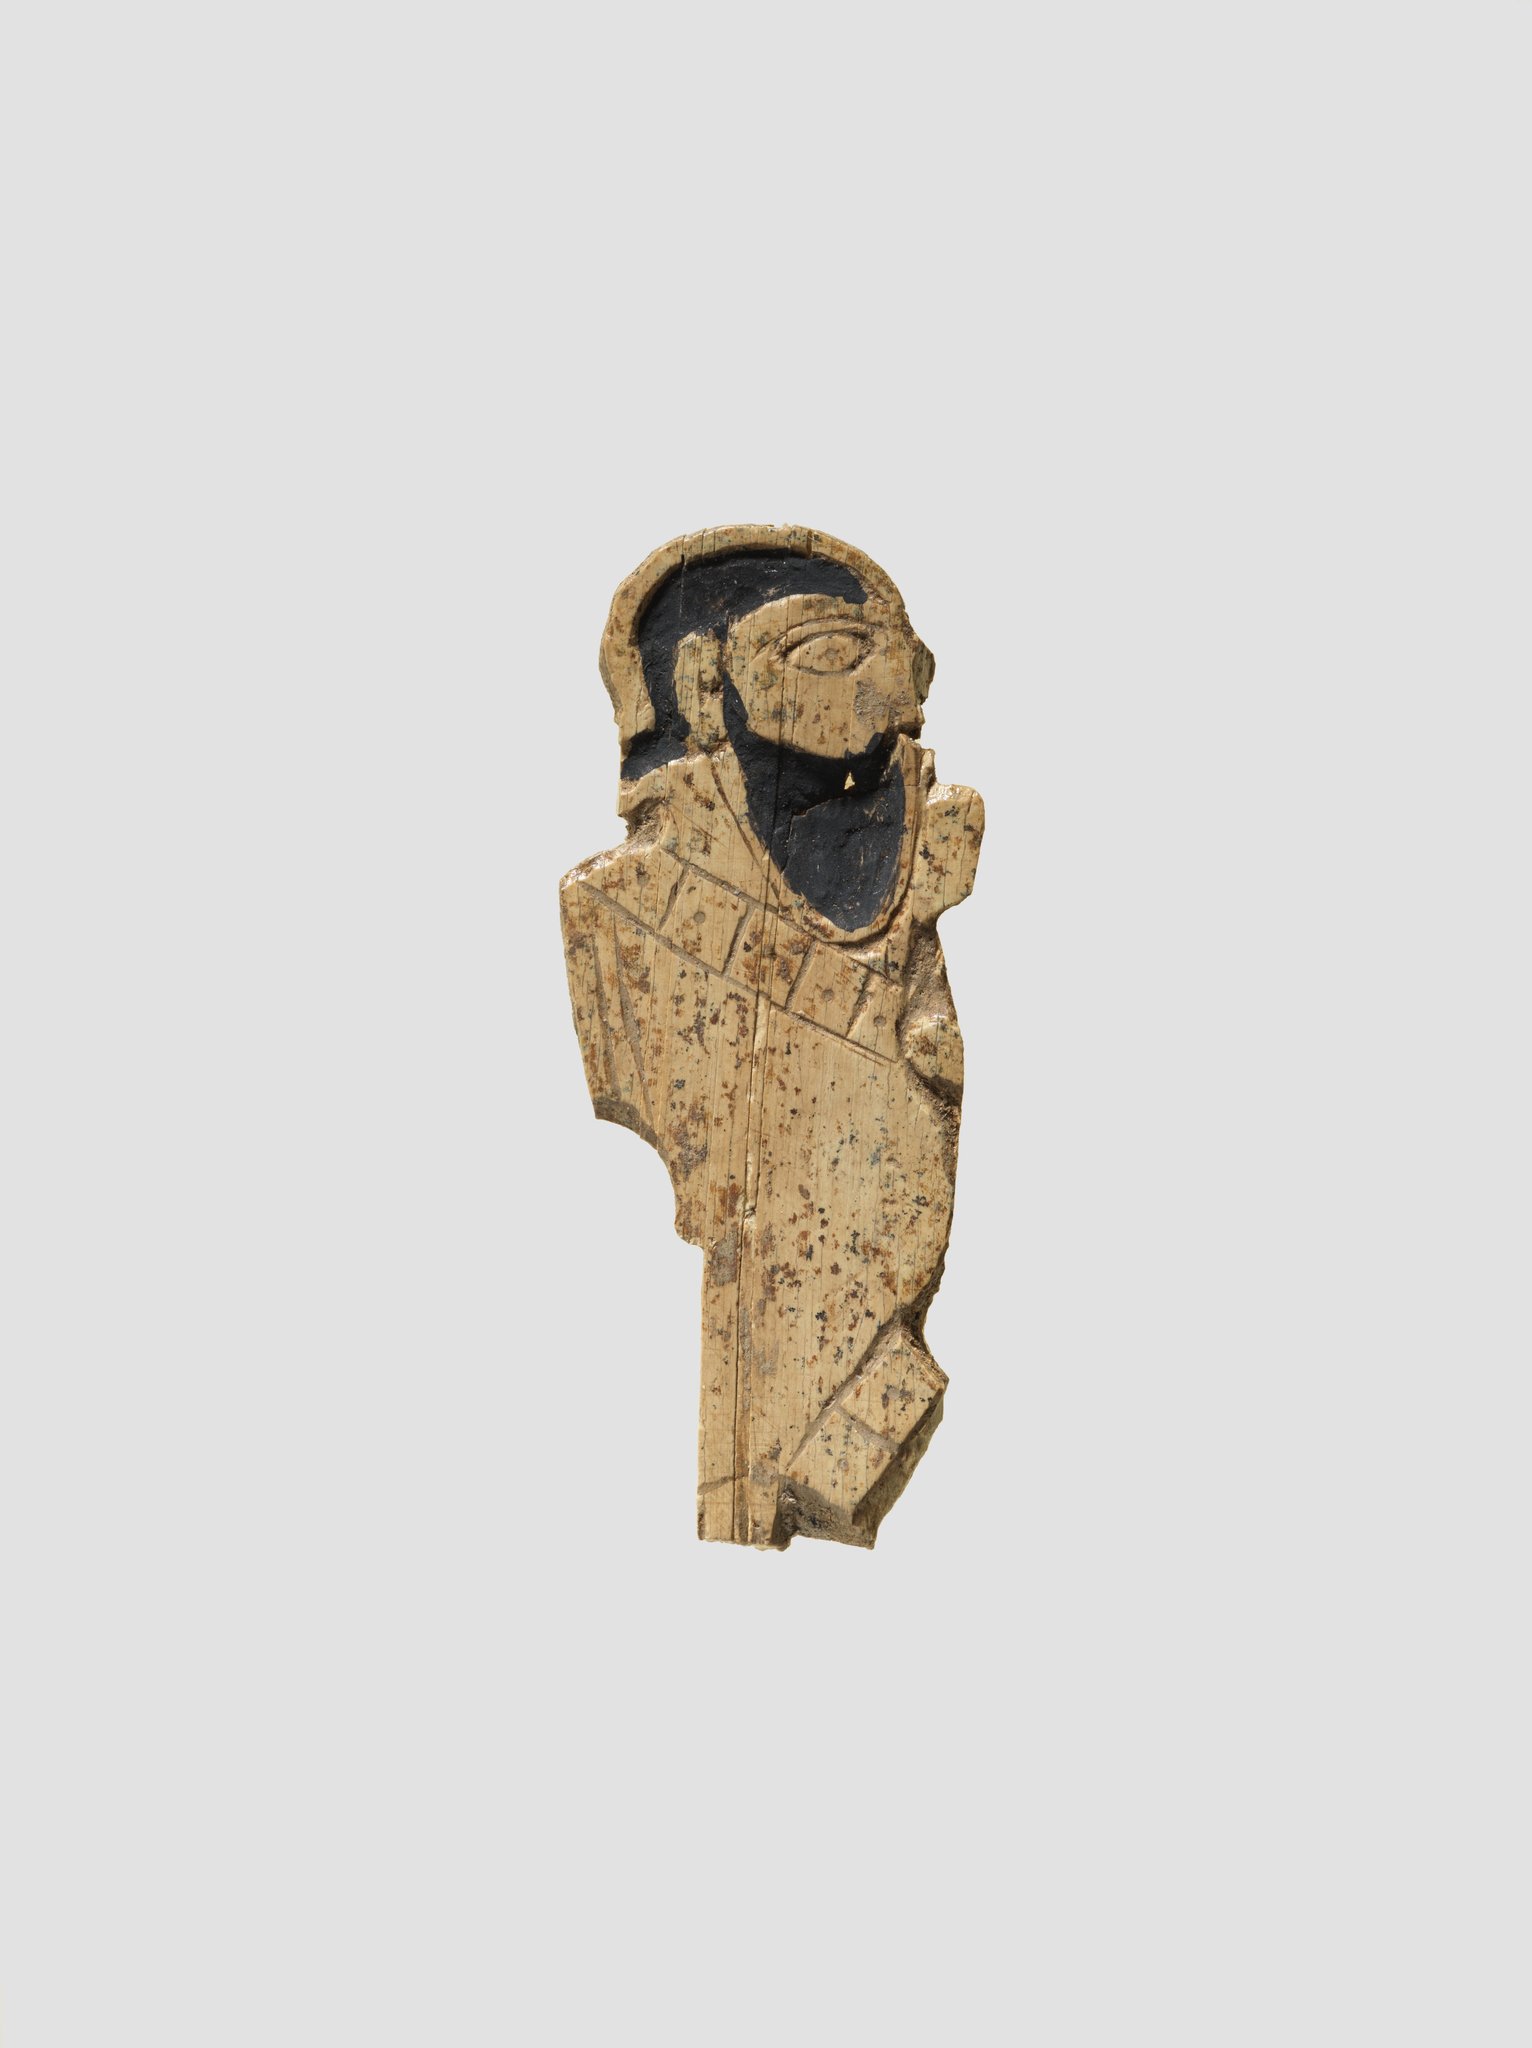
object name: sculpture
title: Figurine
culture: iranian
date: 800-601 BCE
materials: ivory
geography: iran